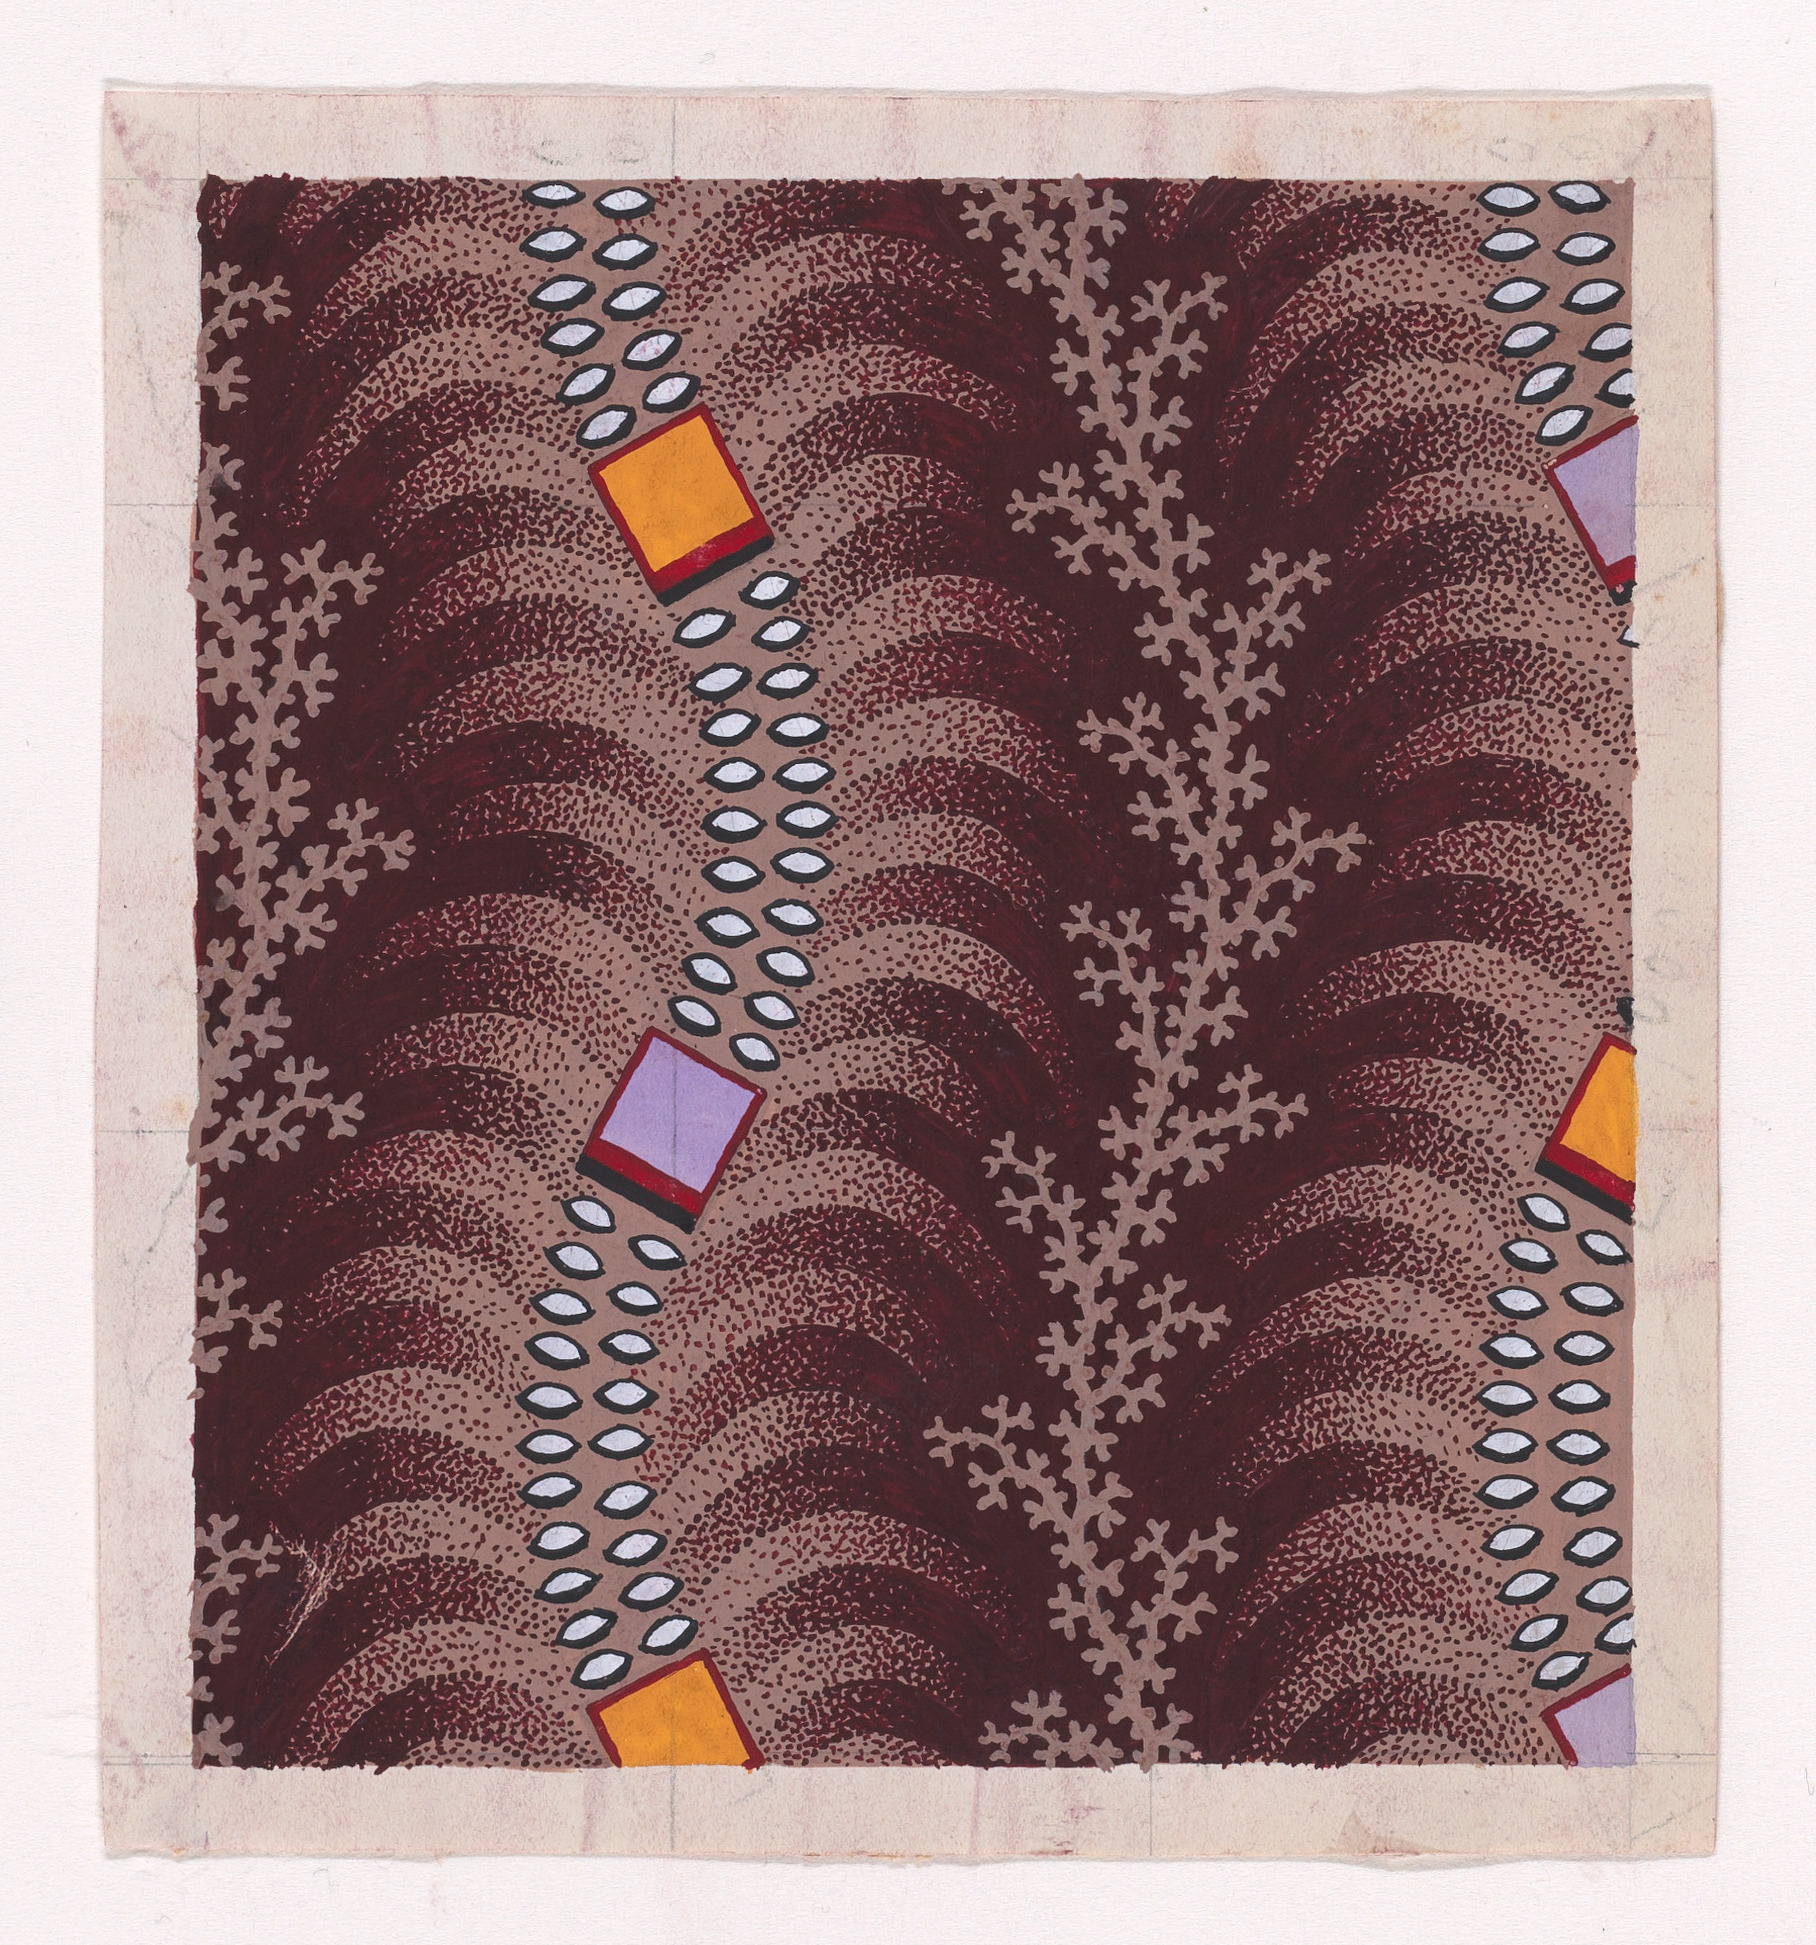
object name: drawing ornament architecture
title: Textile Design with Undulating Vertical Strips of Squares Joined by Lens-Shaped Pearls over Undulating Stylized Palm Leaves Separated by Vertical Garlands of Branches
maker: anonymous, alsatian, 19th century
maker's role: artist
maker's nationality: alsatian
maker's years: 1800-1900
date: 1840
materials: gouache